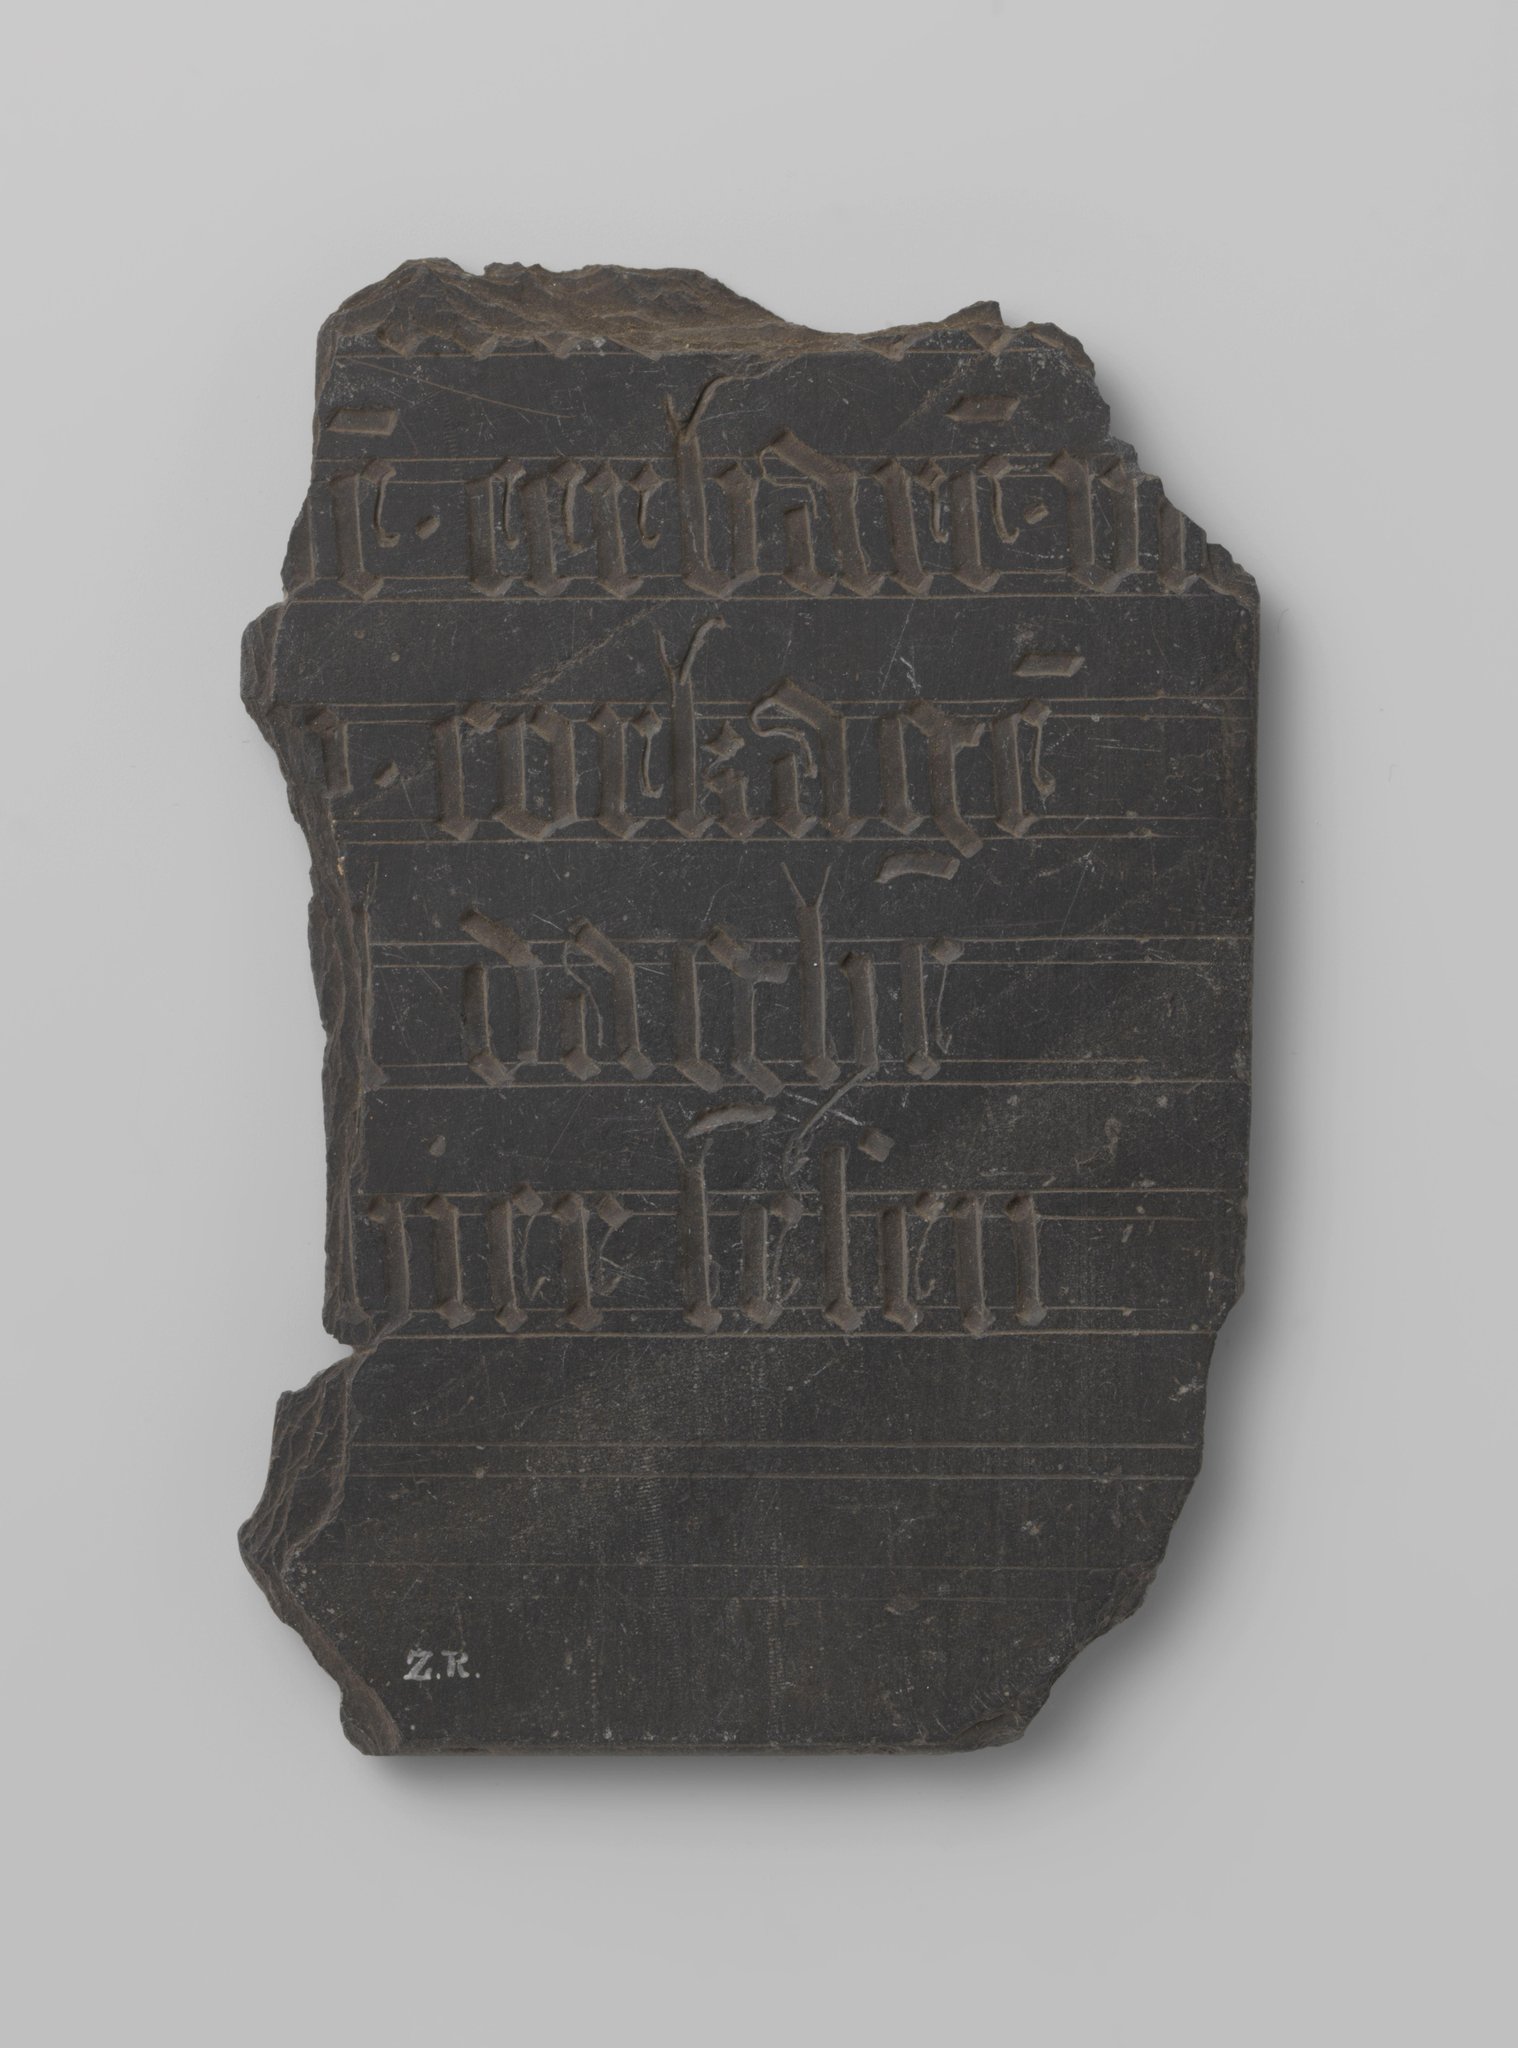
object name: architectural element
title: Fragment van een steen met opschrift.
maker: Anonymous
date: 1500-1700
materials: stone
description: Fragment van een leisteen met opschrift, mogelijk een gedeelte van een grafschrift.